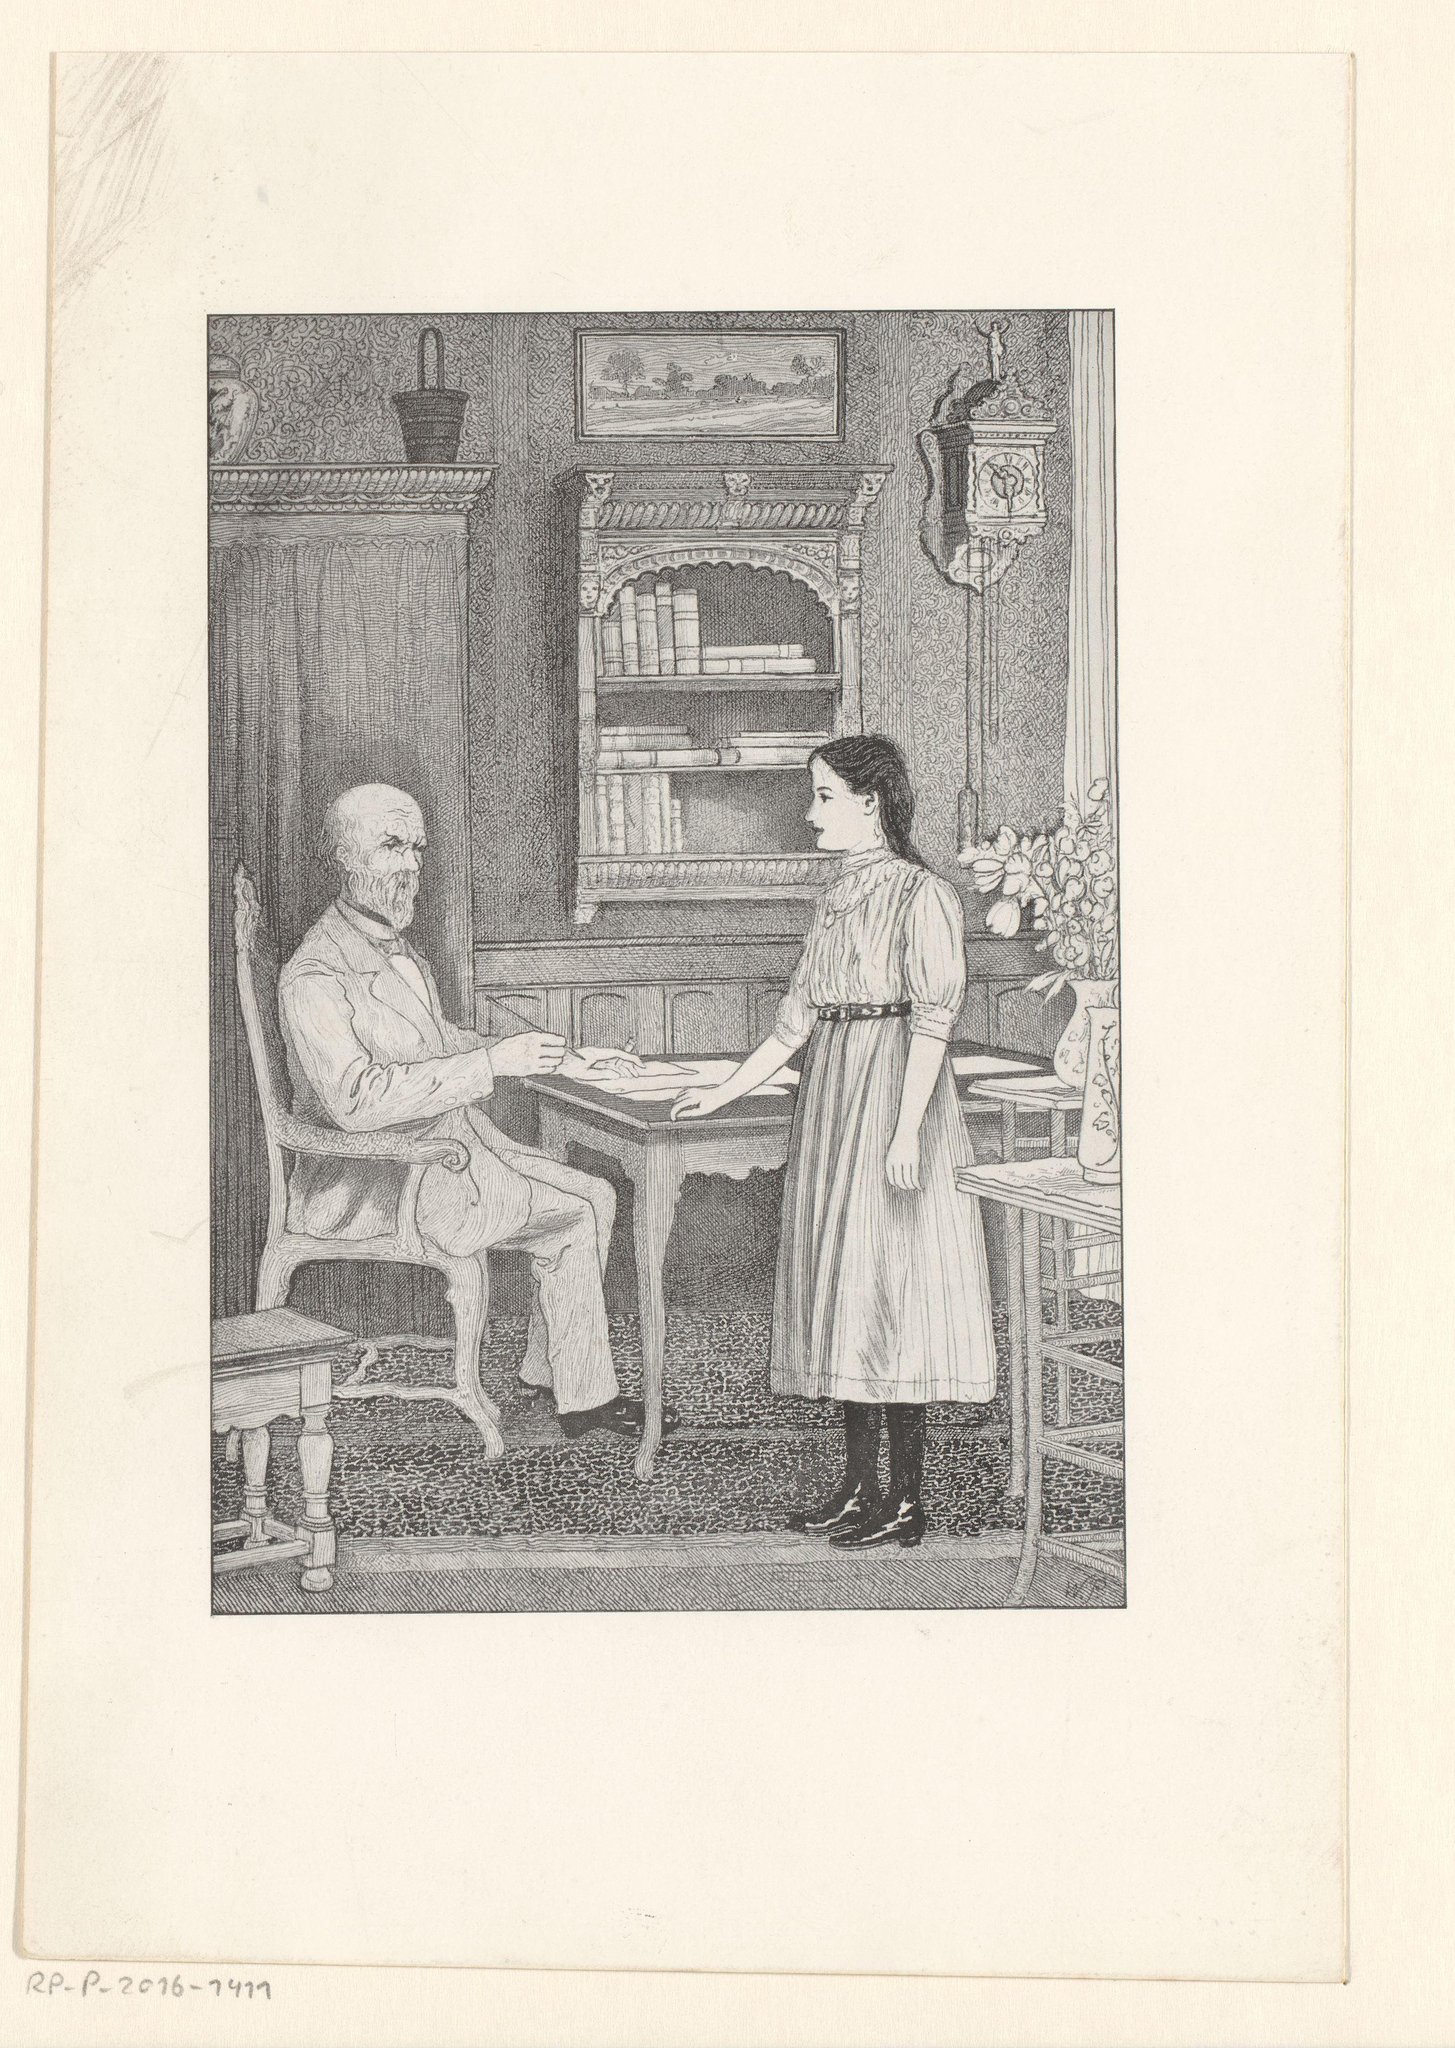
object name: boekillustratie ontwerp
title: Meisje en schrijvende man bij een tafel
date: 1887-1916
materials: paper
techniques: printing block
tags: adolescent, young woman, maiden, writing accessories, sitting figure (+ old male (human being))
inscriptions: collector's mark: Lugt 2228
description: In een interieur, mogelijk een studeerkamer, zit een oude man aan een tafel met een pen in de hand. Voor hem liggen vellen papier. Een meisje staat bij de tafel en leunt erop met haar hand. In de achtergrond een boekenkast.